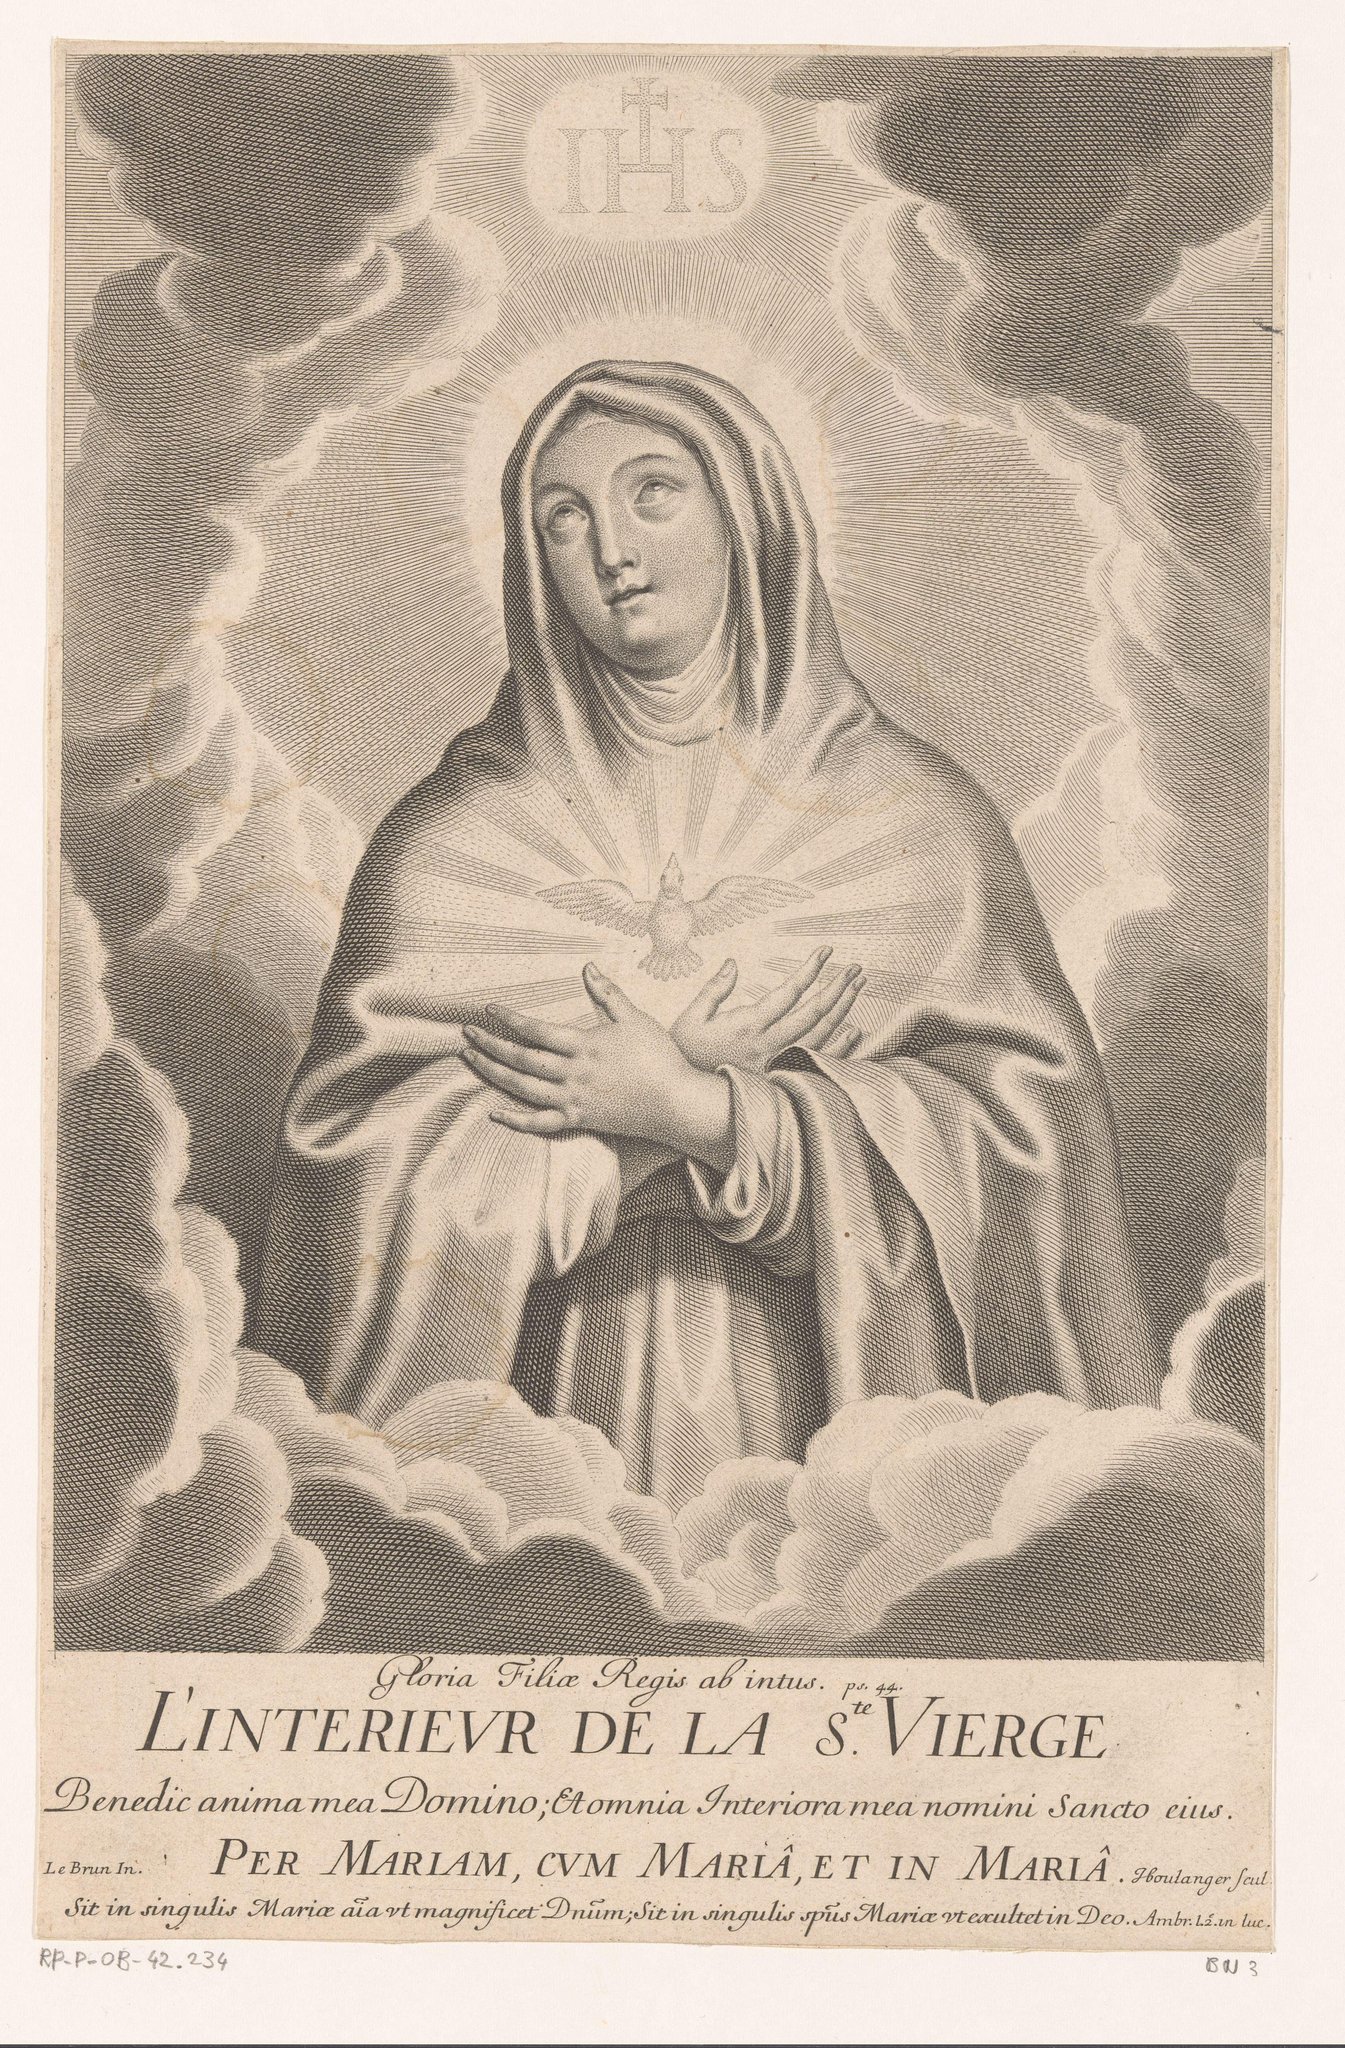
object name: print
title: L'Interieur de la Ste. Vierge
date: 1616-1680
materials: paper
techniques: engraving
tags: trinity inside the opening virgin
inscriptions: collector's mark: Lugt 240